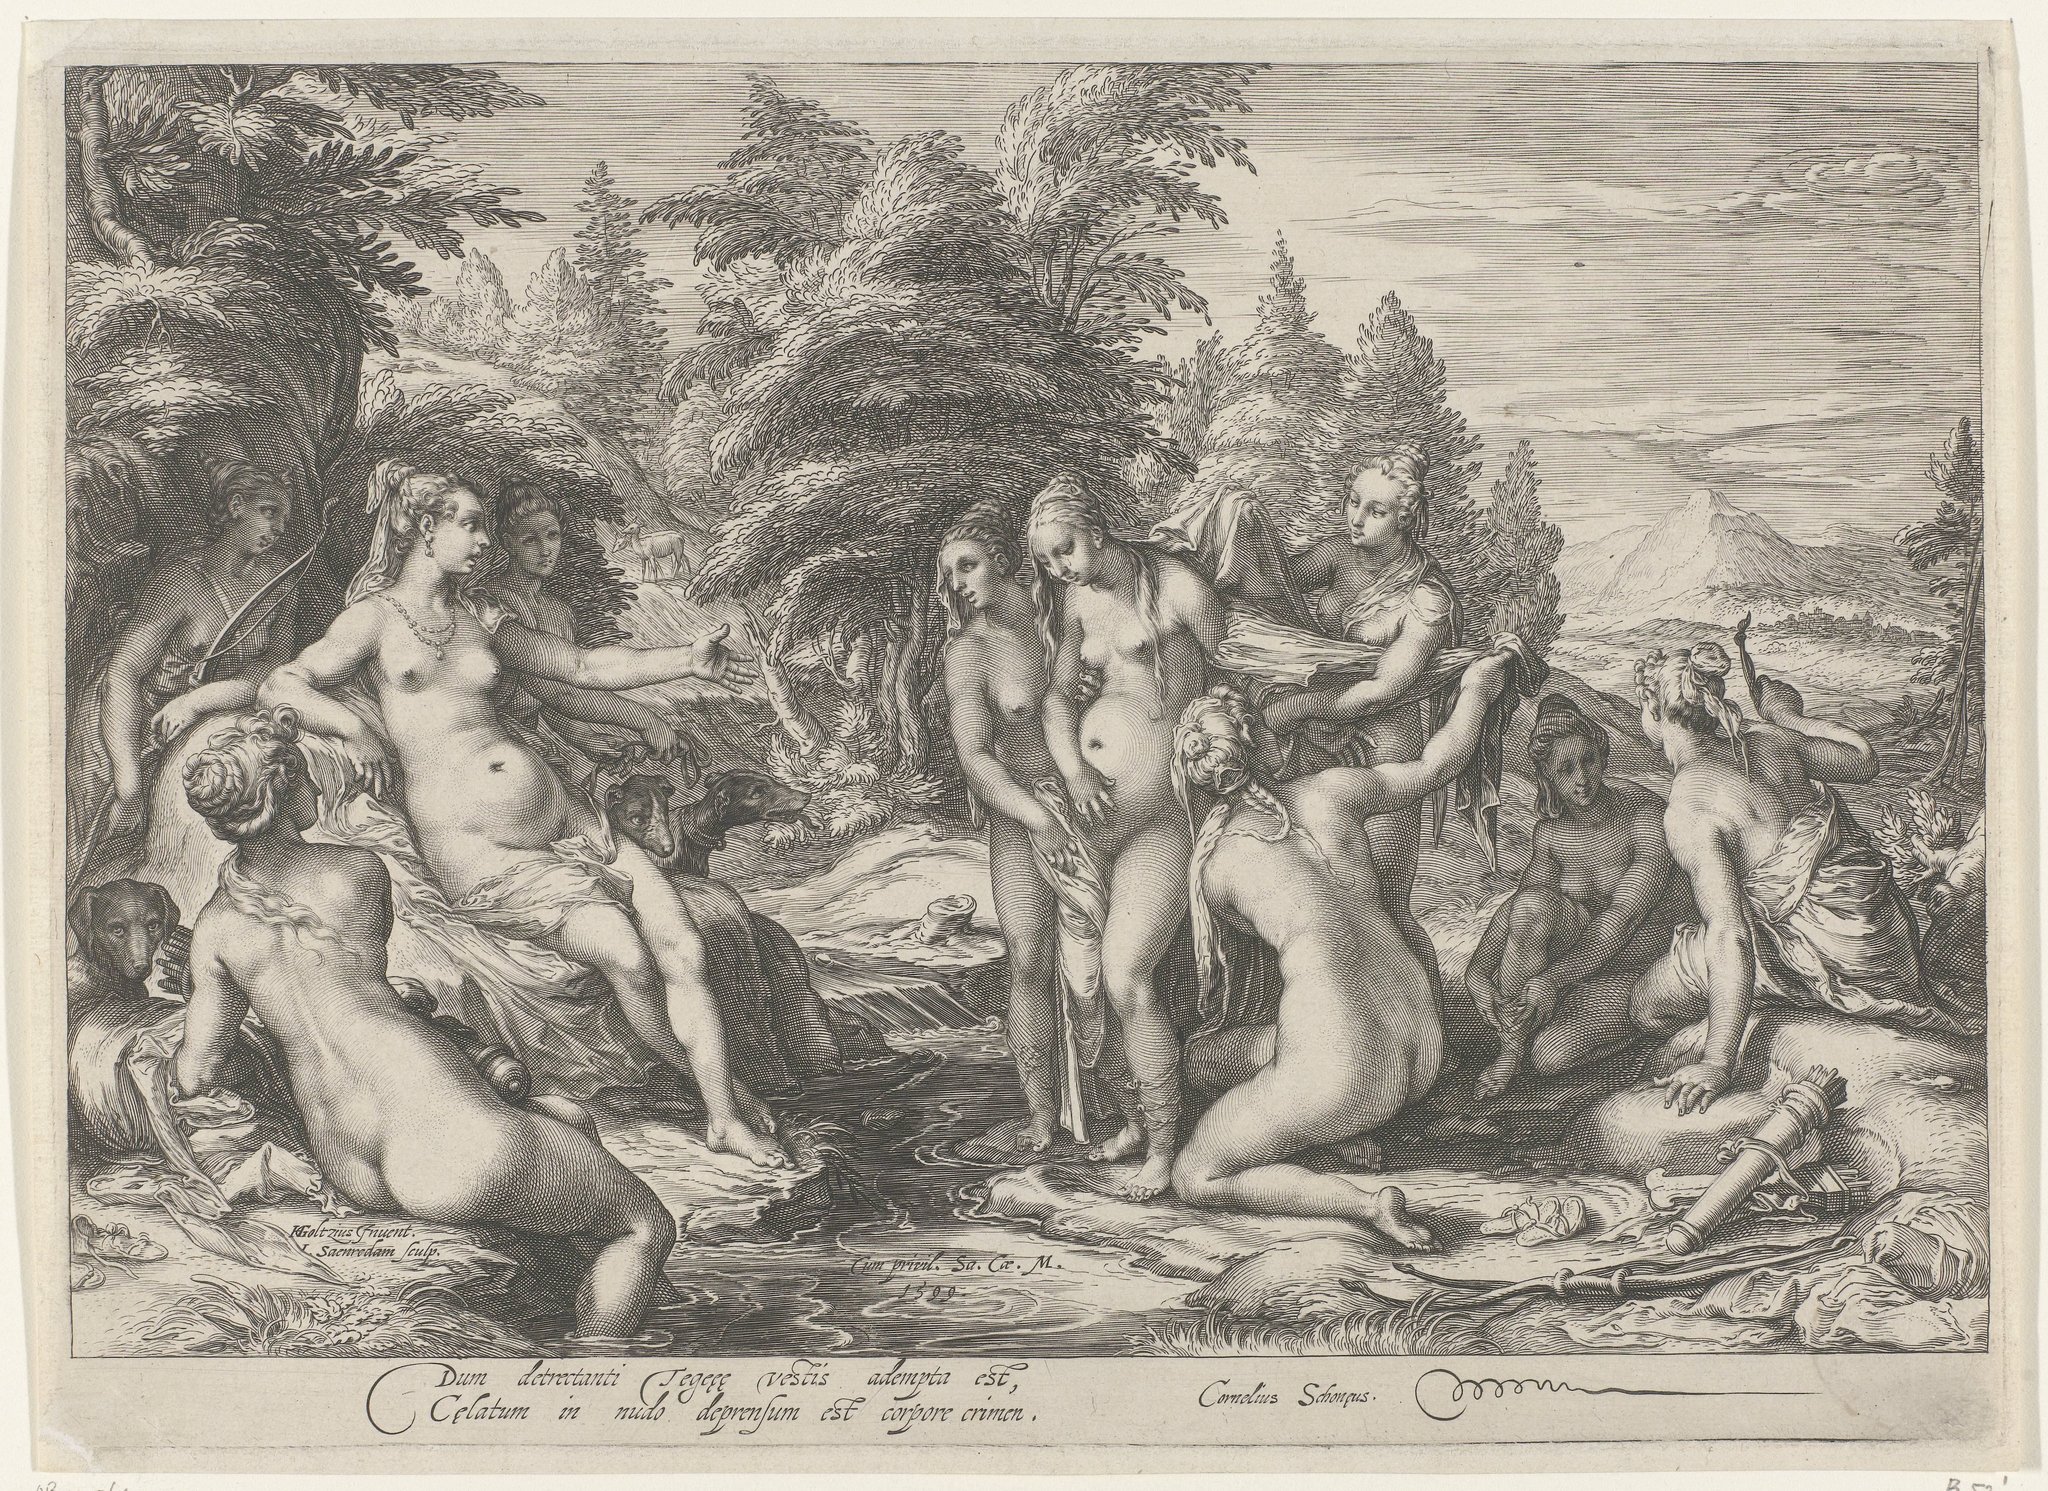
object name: print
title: Diana ontdekt de zwangerschap van Callisto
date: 1599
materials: paper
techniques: engraving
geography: northern netherlands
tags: diana with her nymphs discovers the pregnancy of callisto, pregnancy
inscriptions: collector's mark: Lugt 240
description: De naakte Diana met haar nimfen in de wildernis. Zij wijst beschuldigend naar Callisto, wier kleding door de nimfen opzij wordt getrokken om haar zwangerschap te onthullen. De prent heeft een Latijns onderschrift.